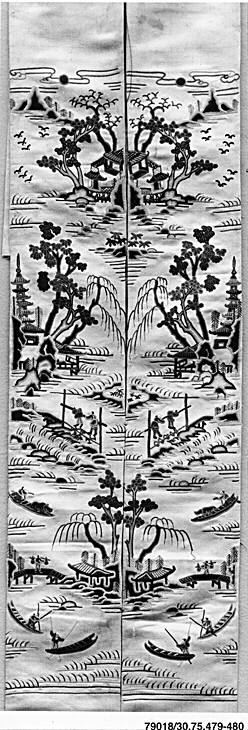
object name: sleeve band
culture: chinese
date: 1801-1900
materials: silk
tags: landscapes,boats